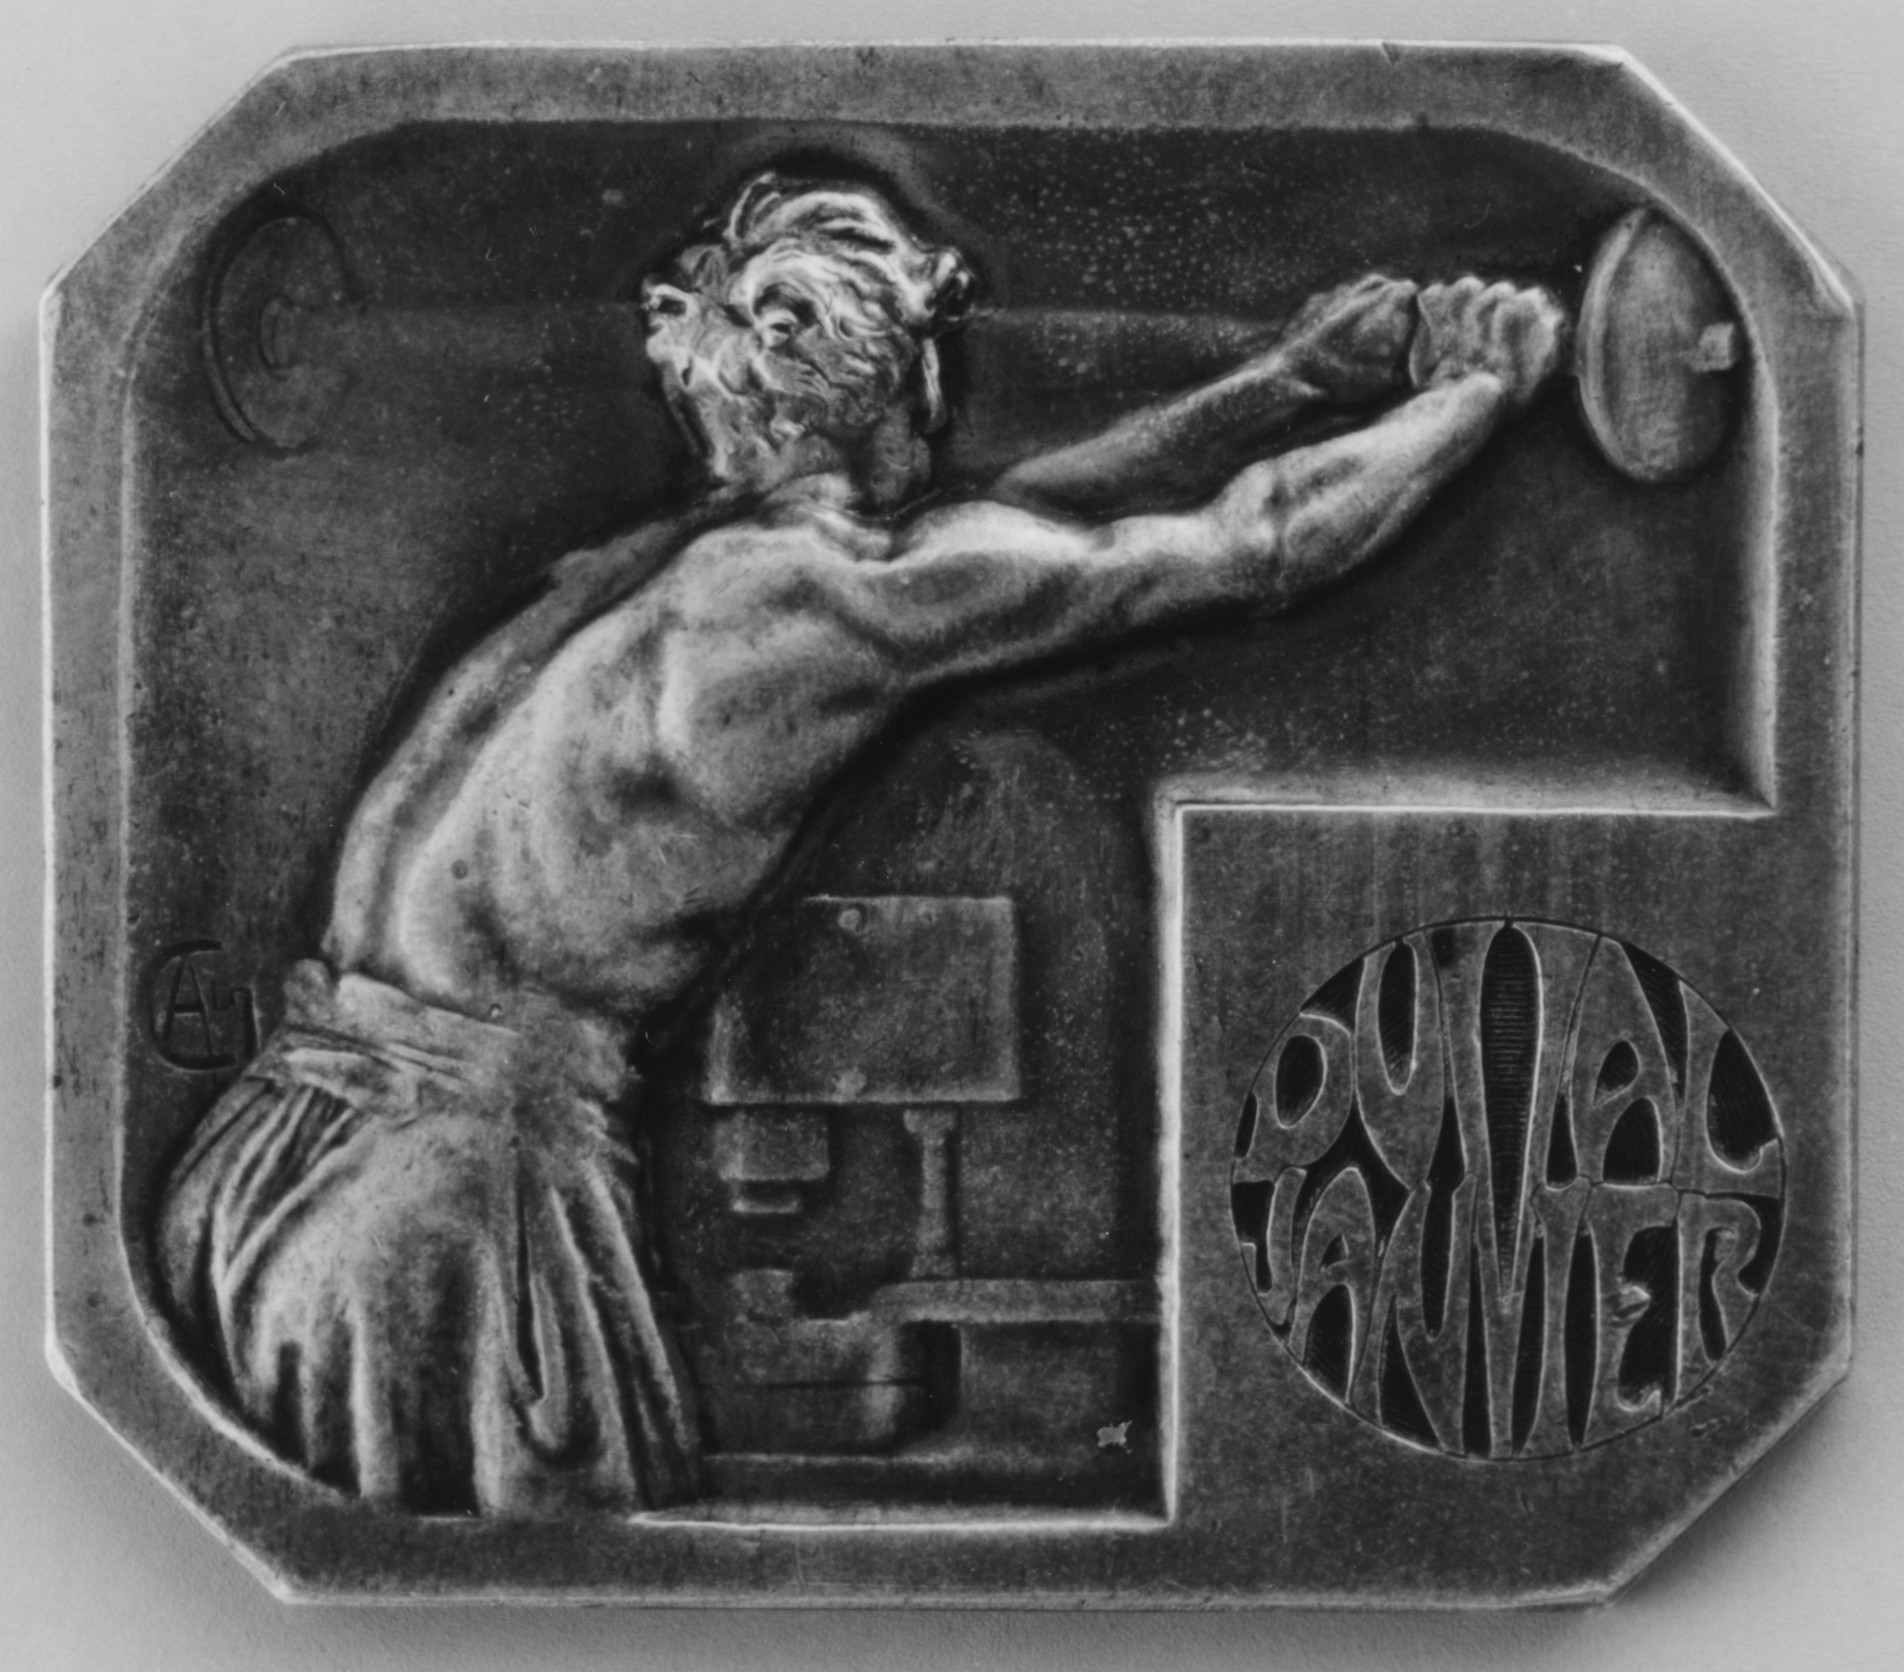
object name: medal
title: Reduction et Frappe de Medailles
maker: alexandre-louis-marie charpentier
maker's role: artist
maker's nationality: french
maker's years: 1856-1909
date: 1900-1910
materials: bronze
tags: men,working